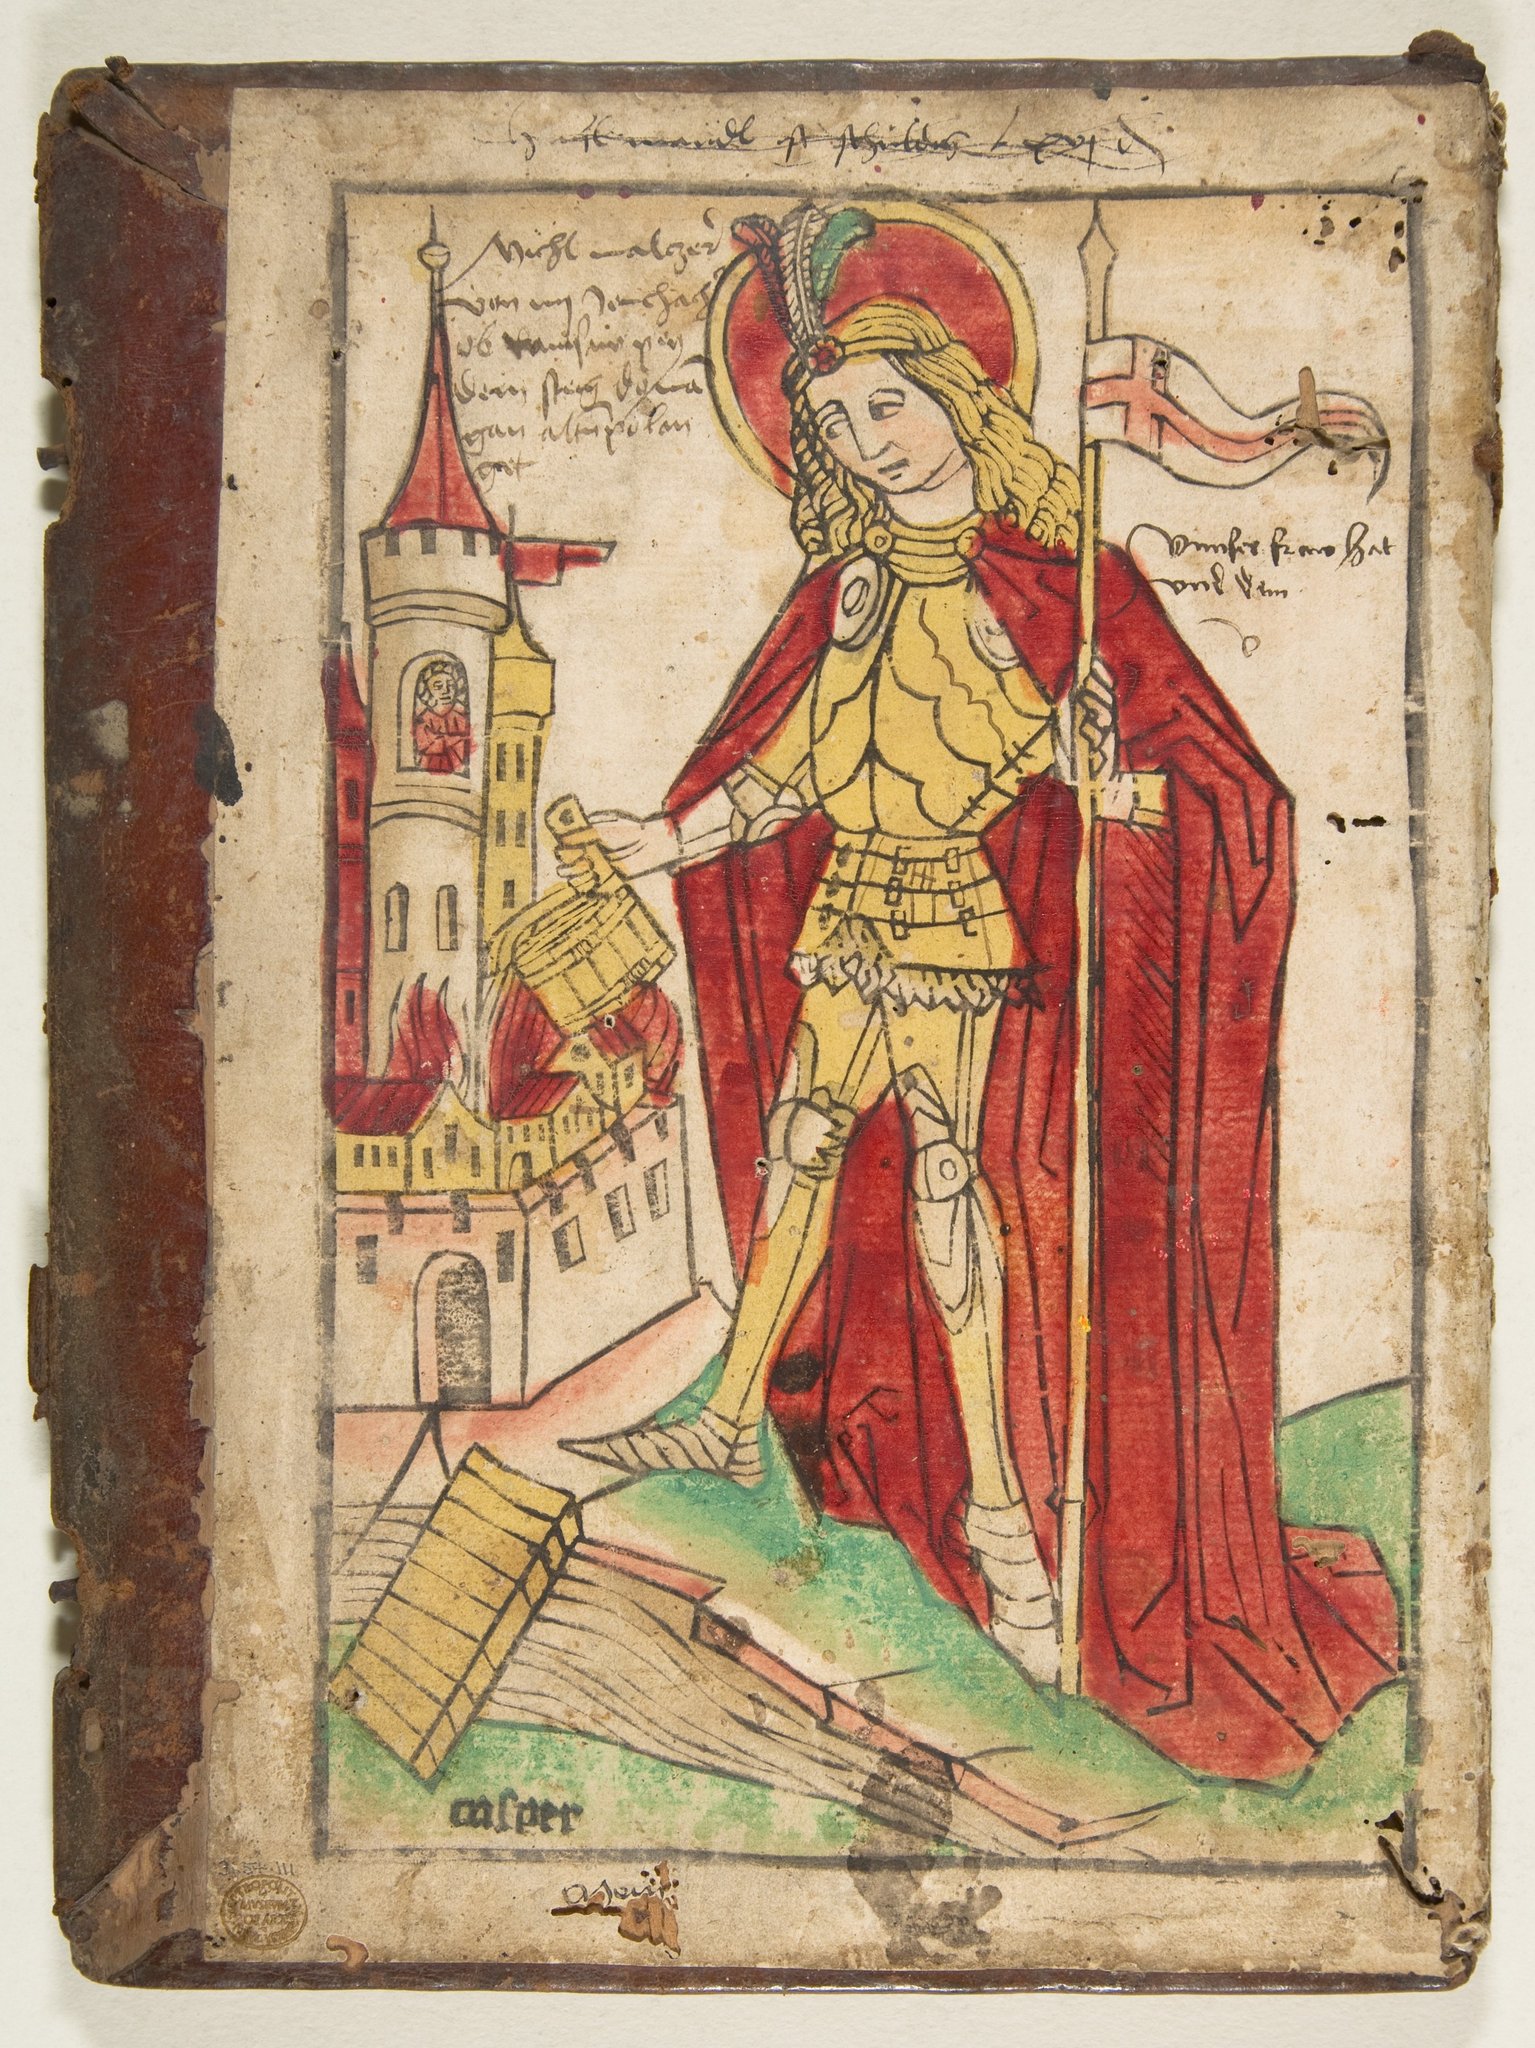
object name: print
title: Saint Florian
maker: casper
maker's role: artist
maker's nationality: german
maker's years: 1400-1500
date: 1460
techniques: hand coloring, woodcut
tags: saints